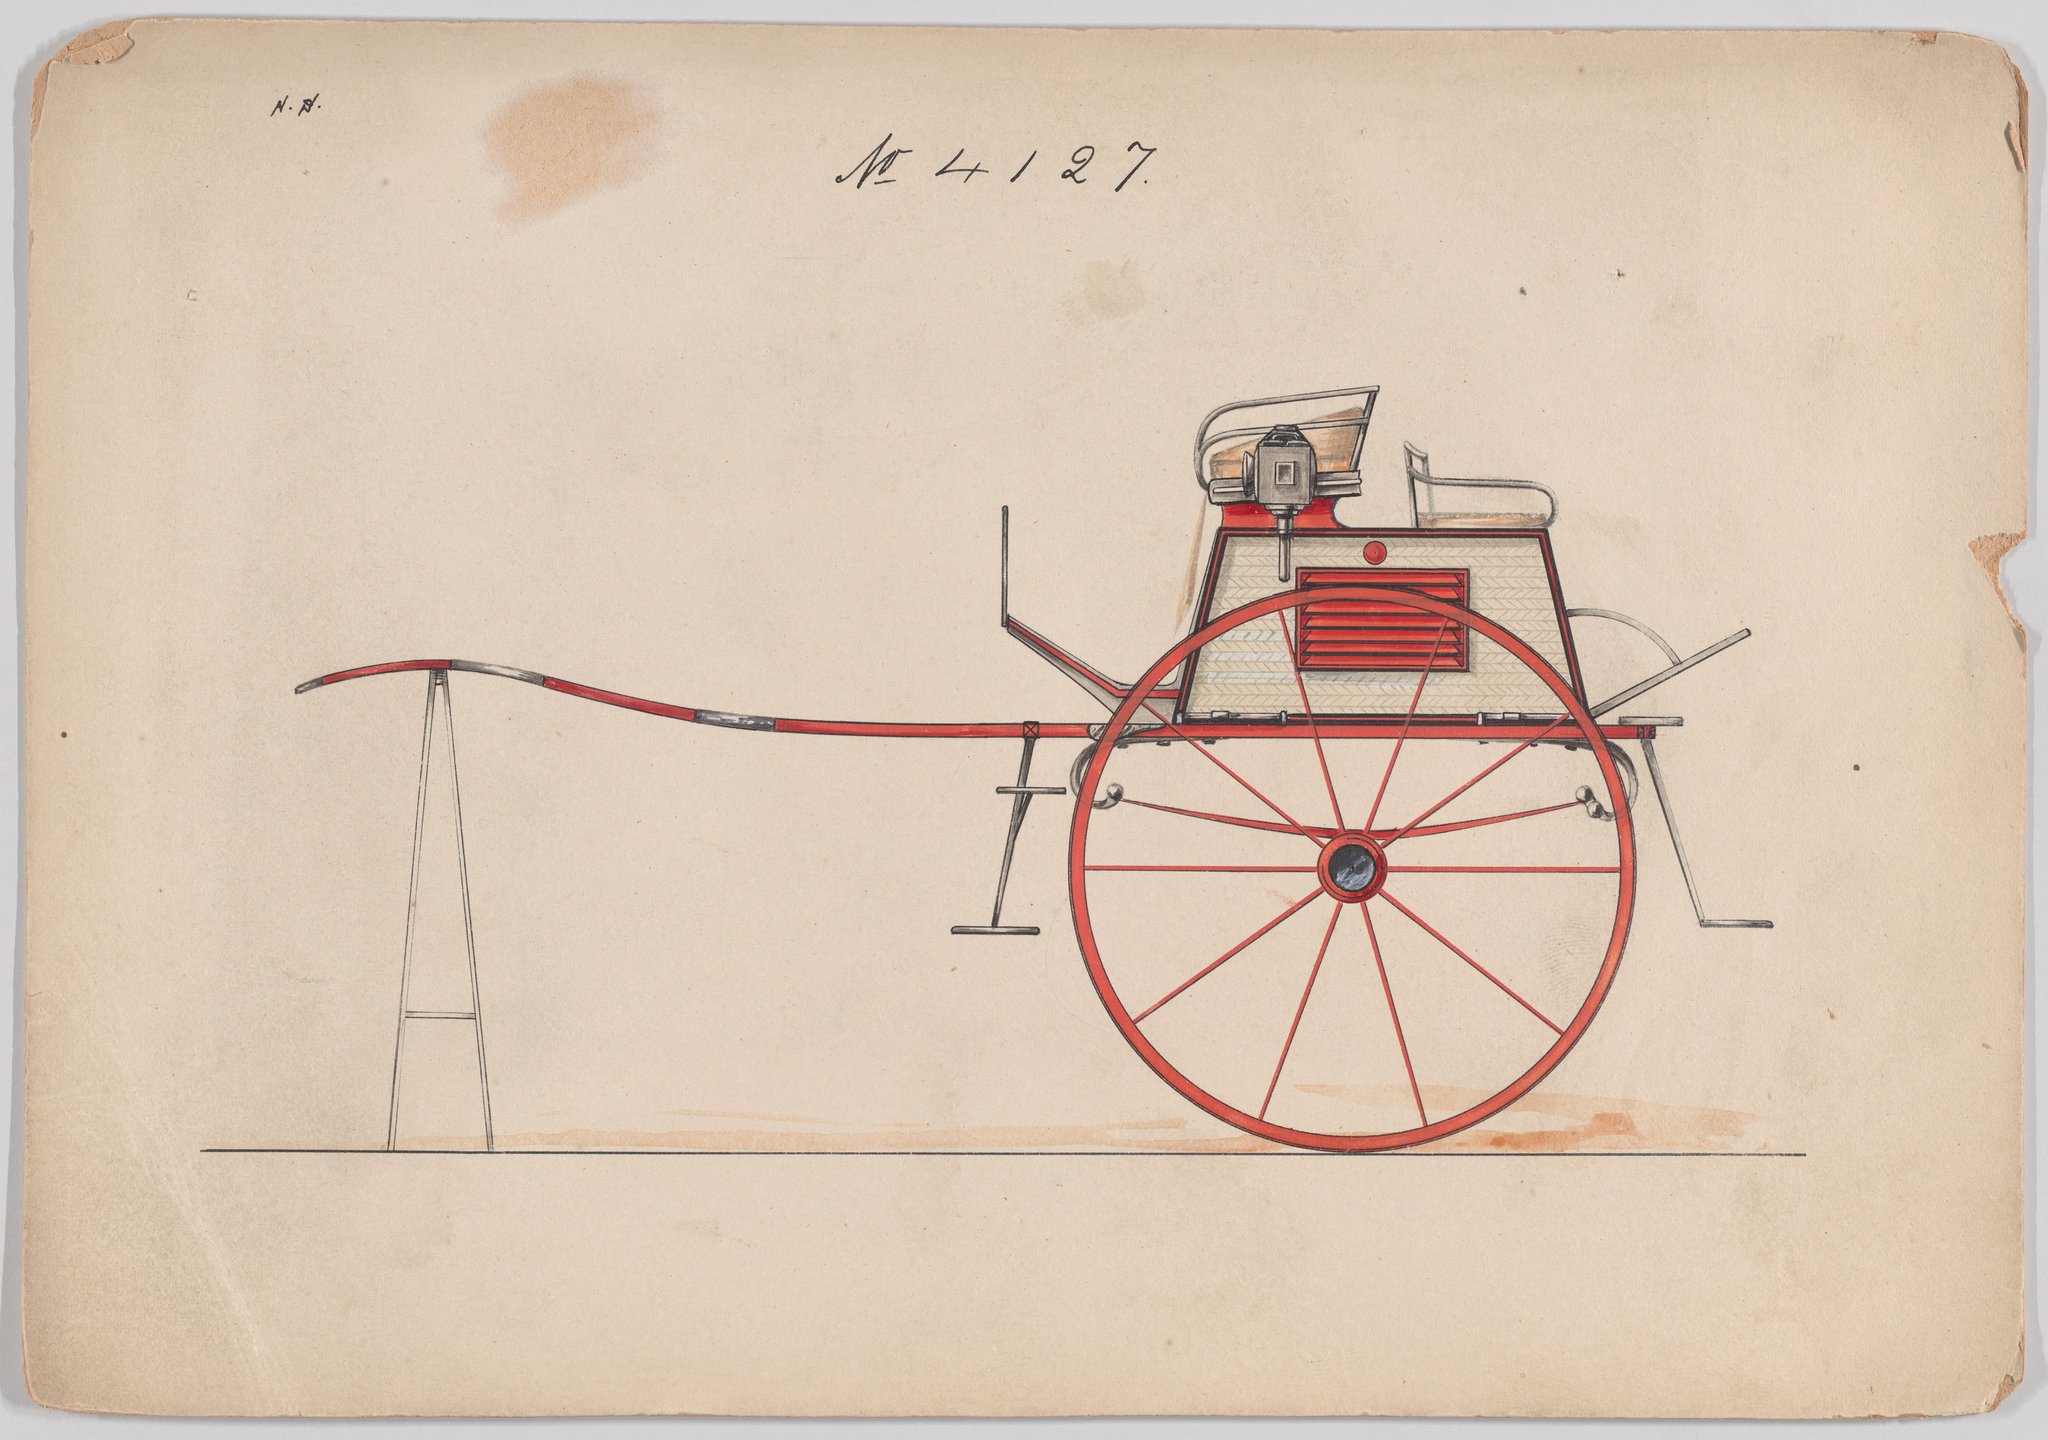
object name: drawing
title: Design for Dog Cart or 2 Wheeler, no. 4127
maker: brewster & co.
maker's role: manufacturer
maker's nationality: american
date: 1891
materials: gouache, ink, watercolor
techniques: pen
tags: carriages